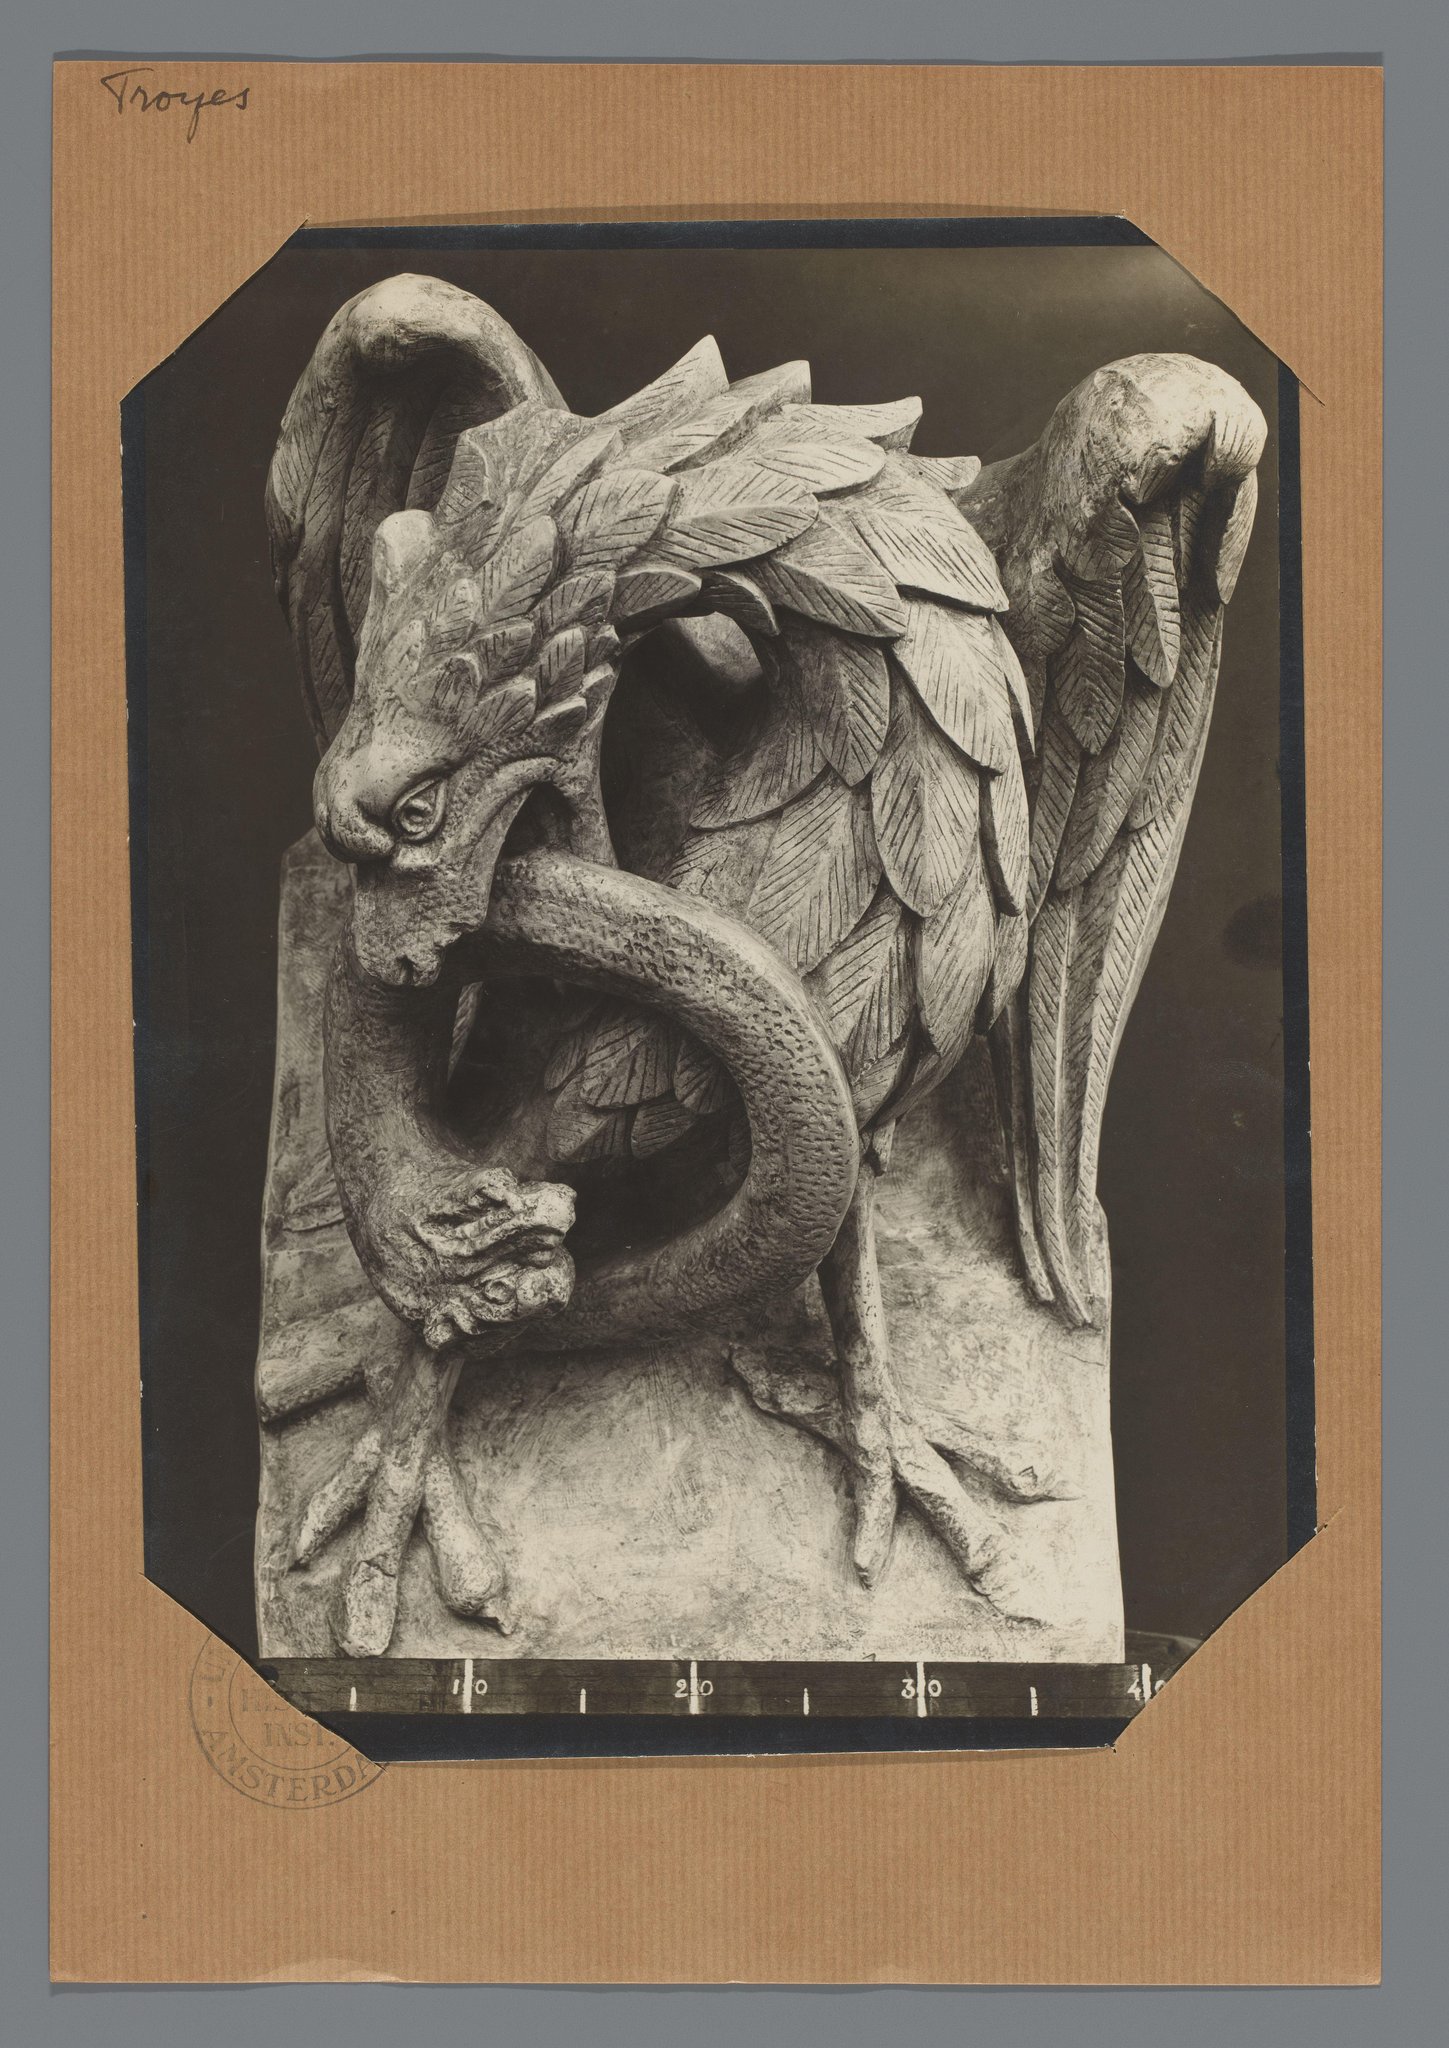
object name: photograph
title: Troyes. Cathédrale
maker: Anonymous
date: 1880-1930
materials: photographic support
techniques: gelatin silver print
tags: kathedraal van troyes